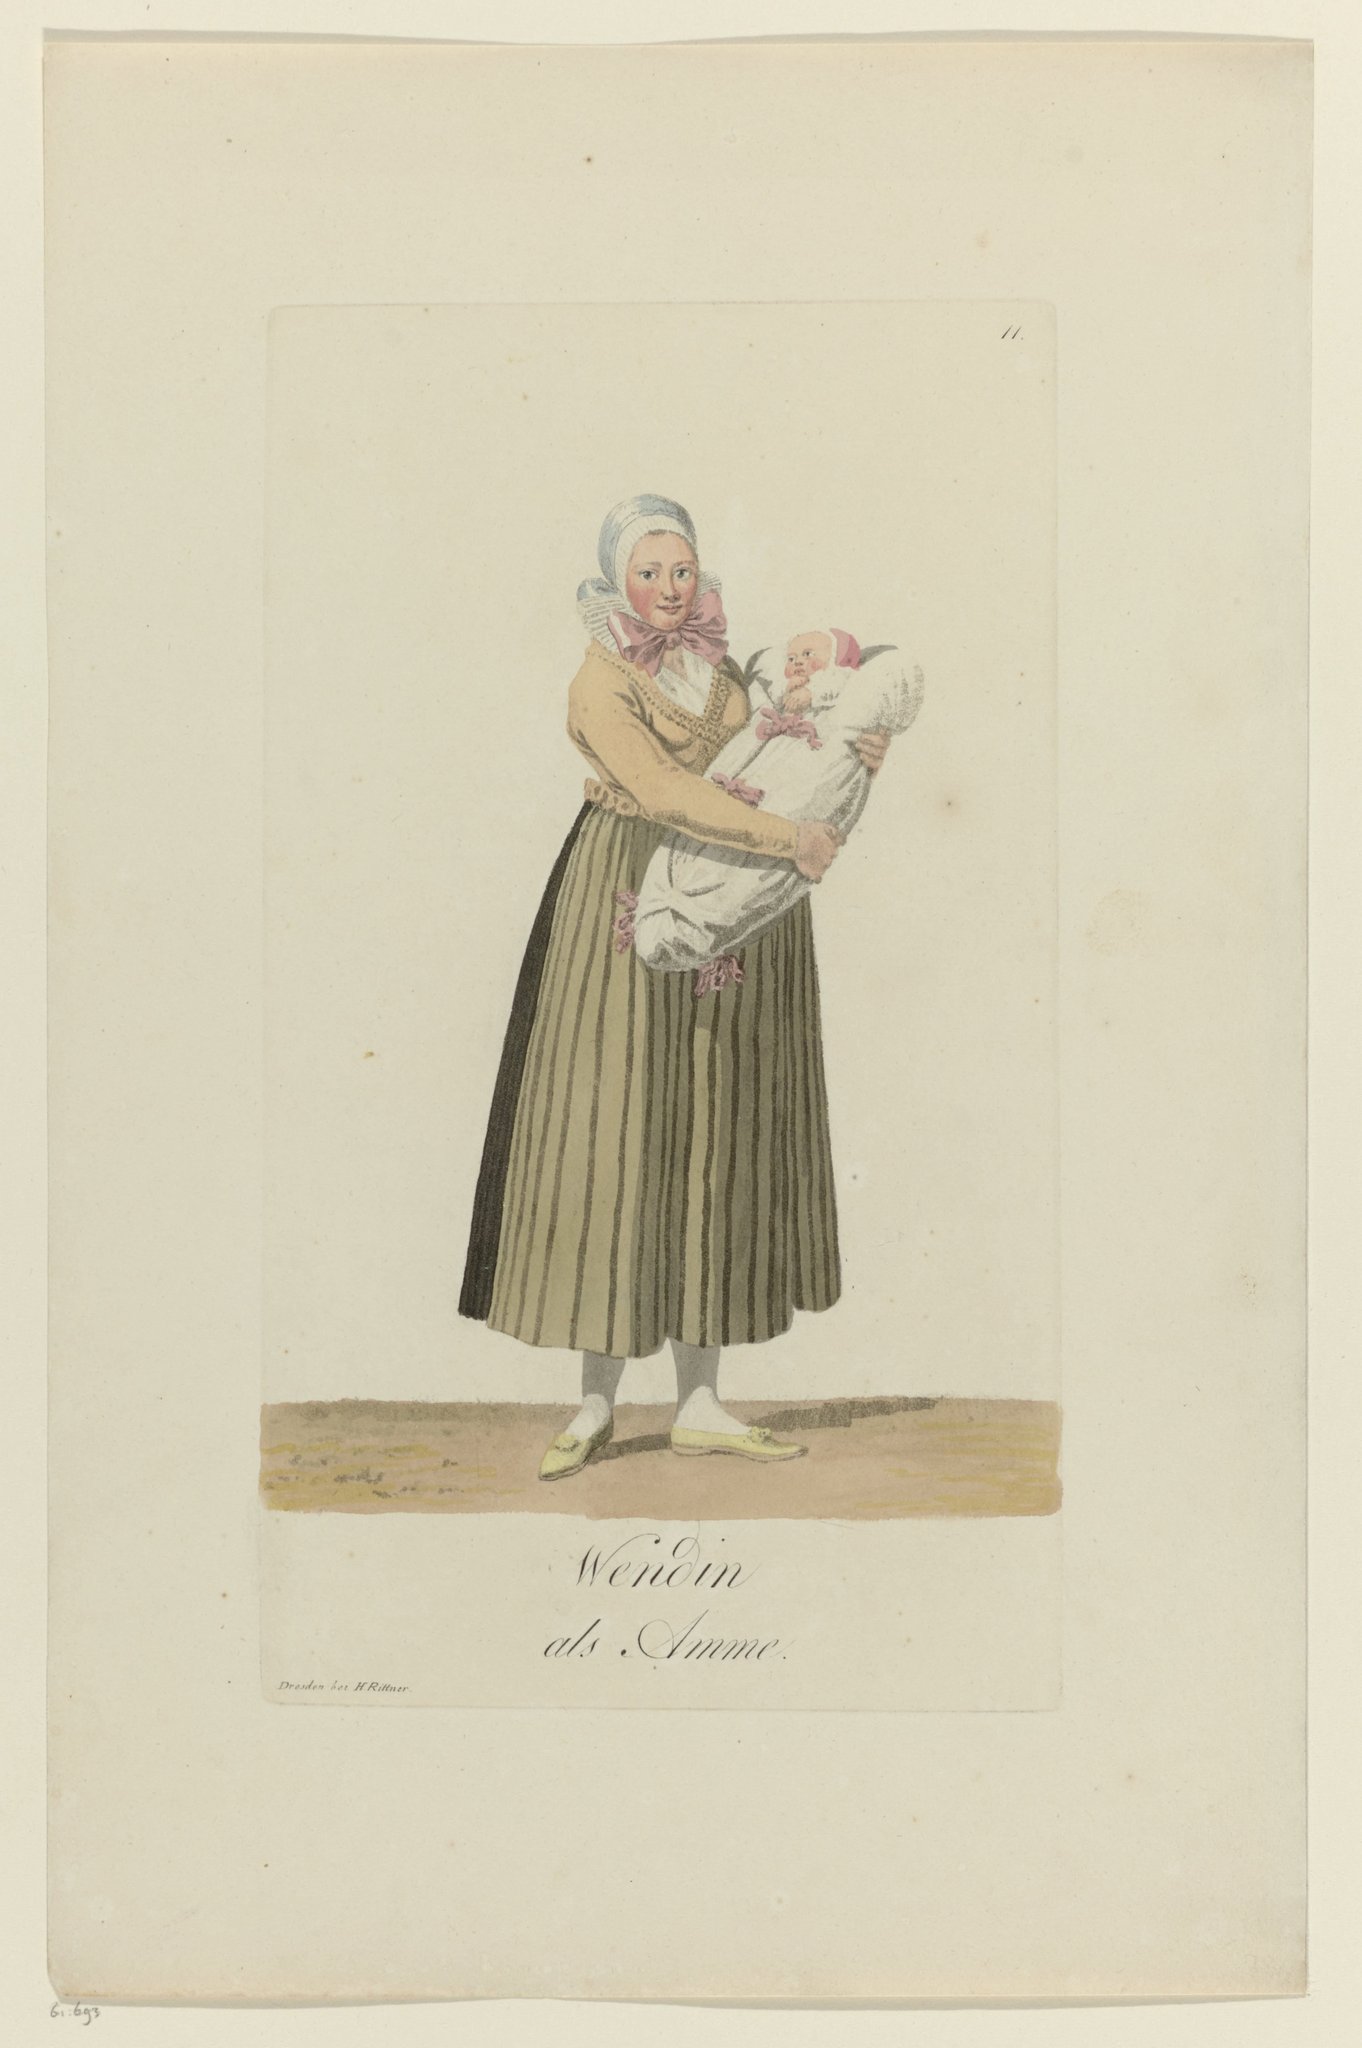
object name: print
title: Wendische vrouw als kraamhulp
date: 1803-1808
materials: paper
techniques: aquatint, etching, hand coloring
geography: dresden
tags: folk costume, regional costume, dry-nurse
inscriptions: collector's mark: Lugt 2228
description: In de deelstaat Saksen zijn de Wenden (historische naam) beter bekent als de Sorben.